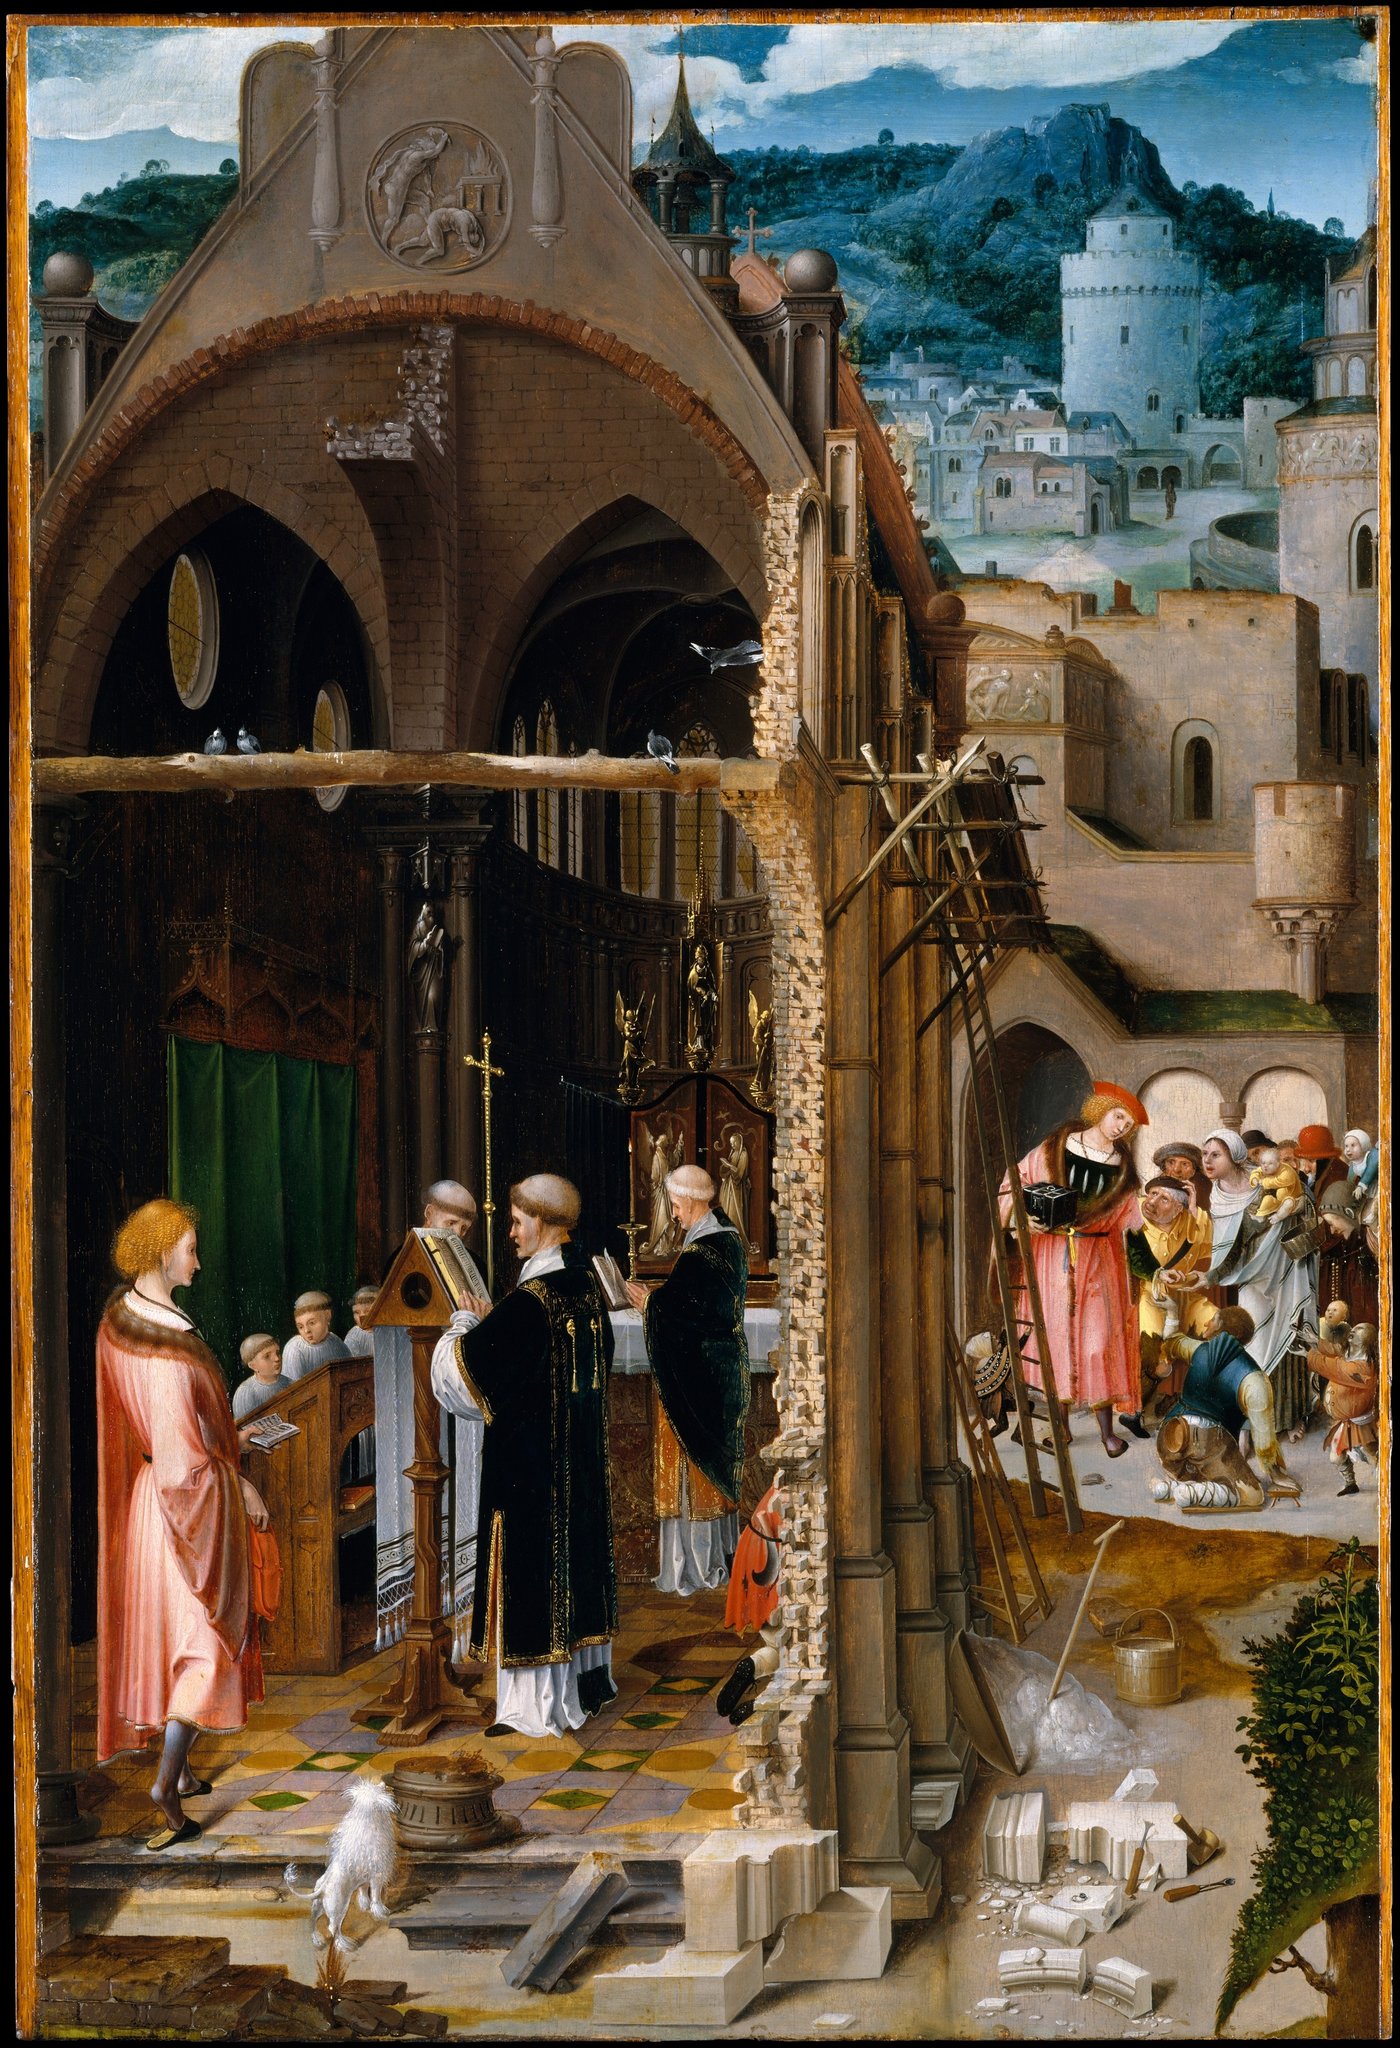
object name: painting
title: A Sermon on Charity (possibly the Conversion of Saint Anthony)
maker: netherlandish (antwerp mannerist) painter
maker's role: artist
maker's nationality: netherlandish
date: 1520-1525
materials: oil, wood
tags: interiors,churches,children,men,women,reading,dogs,saint anthony